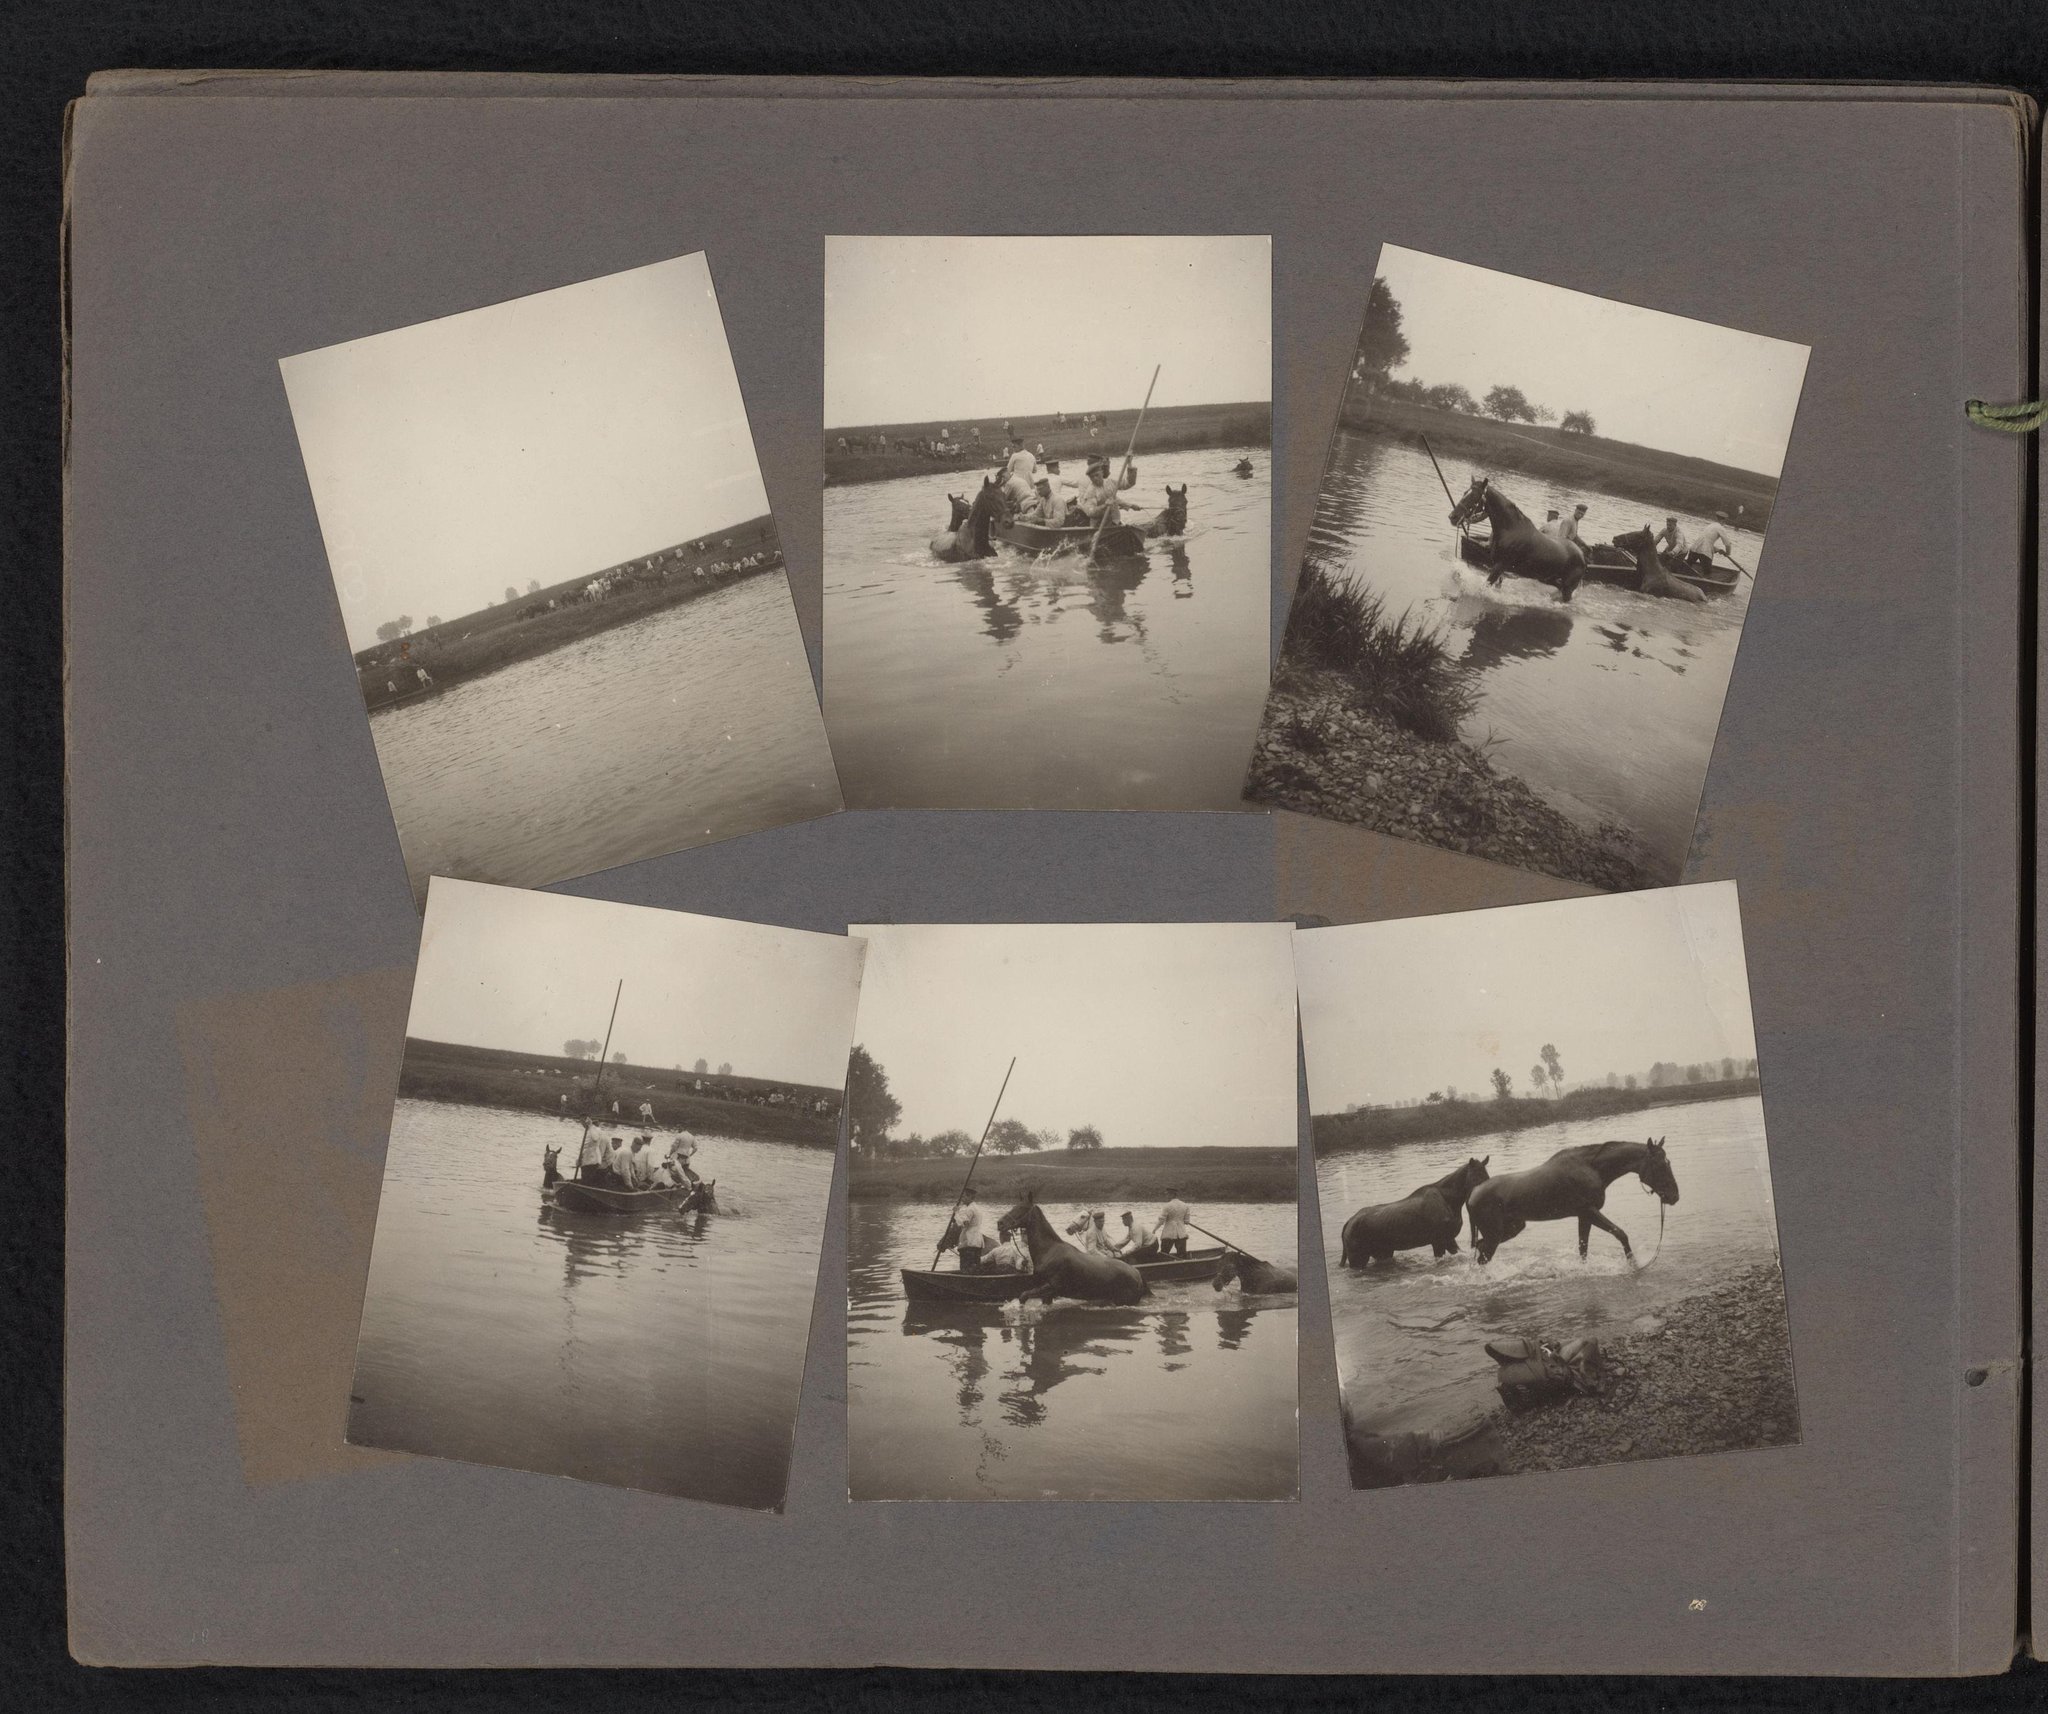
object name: album leaf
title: Oversteken van een rivier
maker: Anonymous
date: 1905-1906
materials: cardboard, photographic support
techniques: gelatin silver print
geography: germany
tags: arthur moos, crossing a river, military training, horse, germany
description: Albumblad met zes foto's van militaire oefening in het oversteken van een rivier met boten en paarden. Onderdeel van het fotoalbum van Arthur Moos tijdens zijn militaire diensttijd bij het 20e regiment Ulanen, Ludwigsburg, 1905-1906.